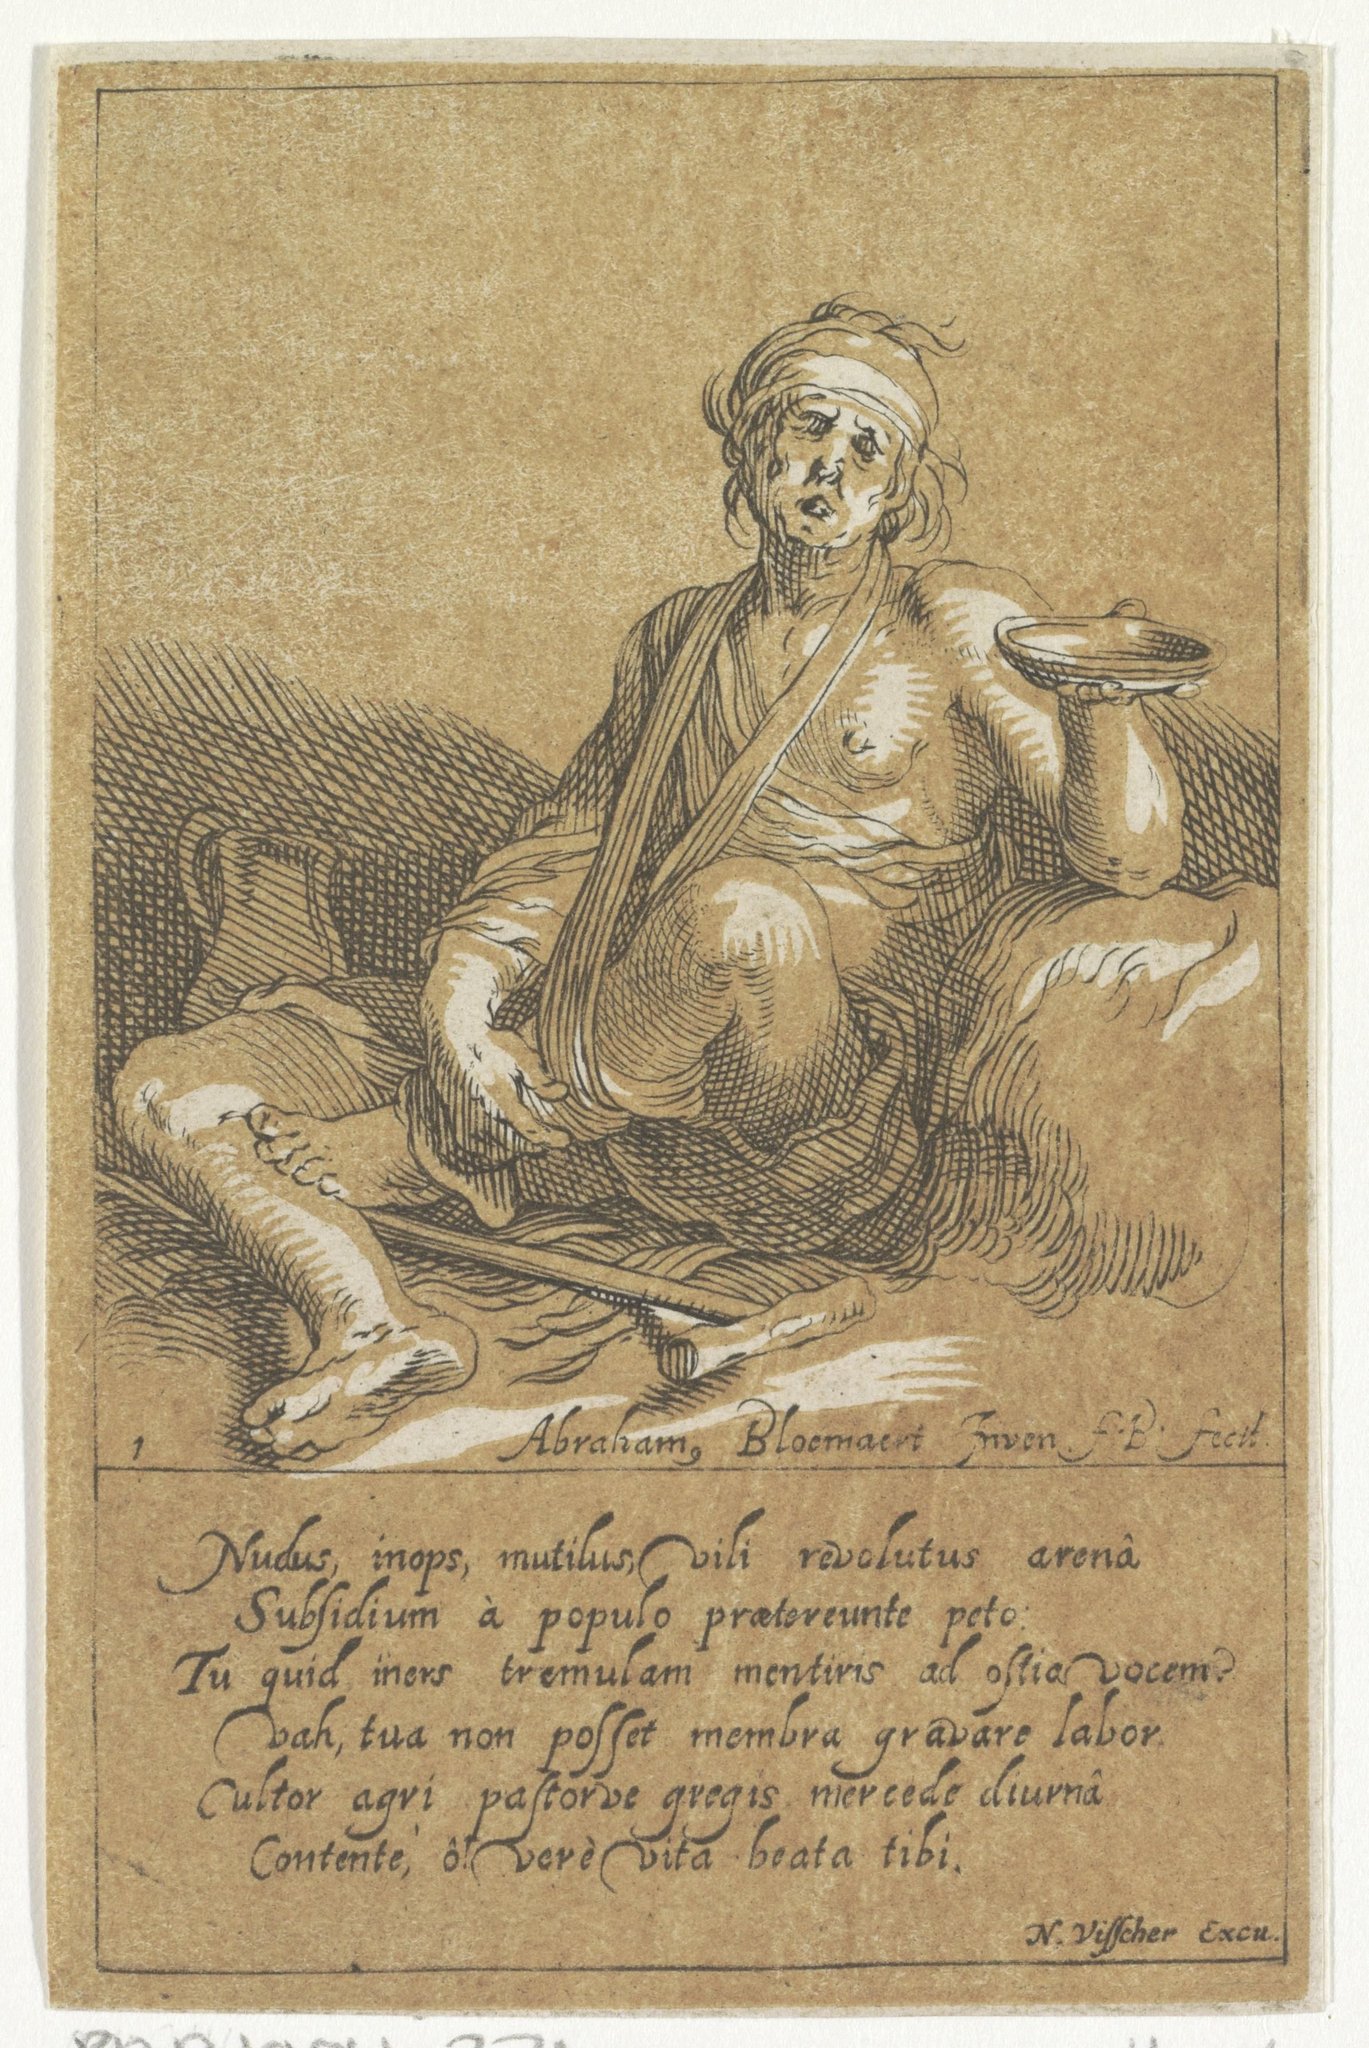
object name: print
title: Zittende bedelaar met zijn been in een mitella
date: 1635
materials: paper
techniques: woodcut, etching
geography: amsterdam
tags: disabilities, deformations, beggar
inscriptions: collector's mark: Lugt 2228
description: In de ondermarge zes regels Latijnse tekst. Linksonder het getal '1'.